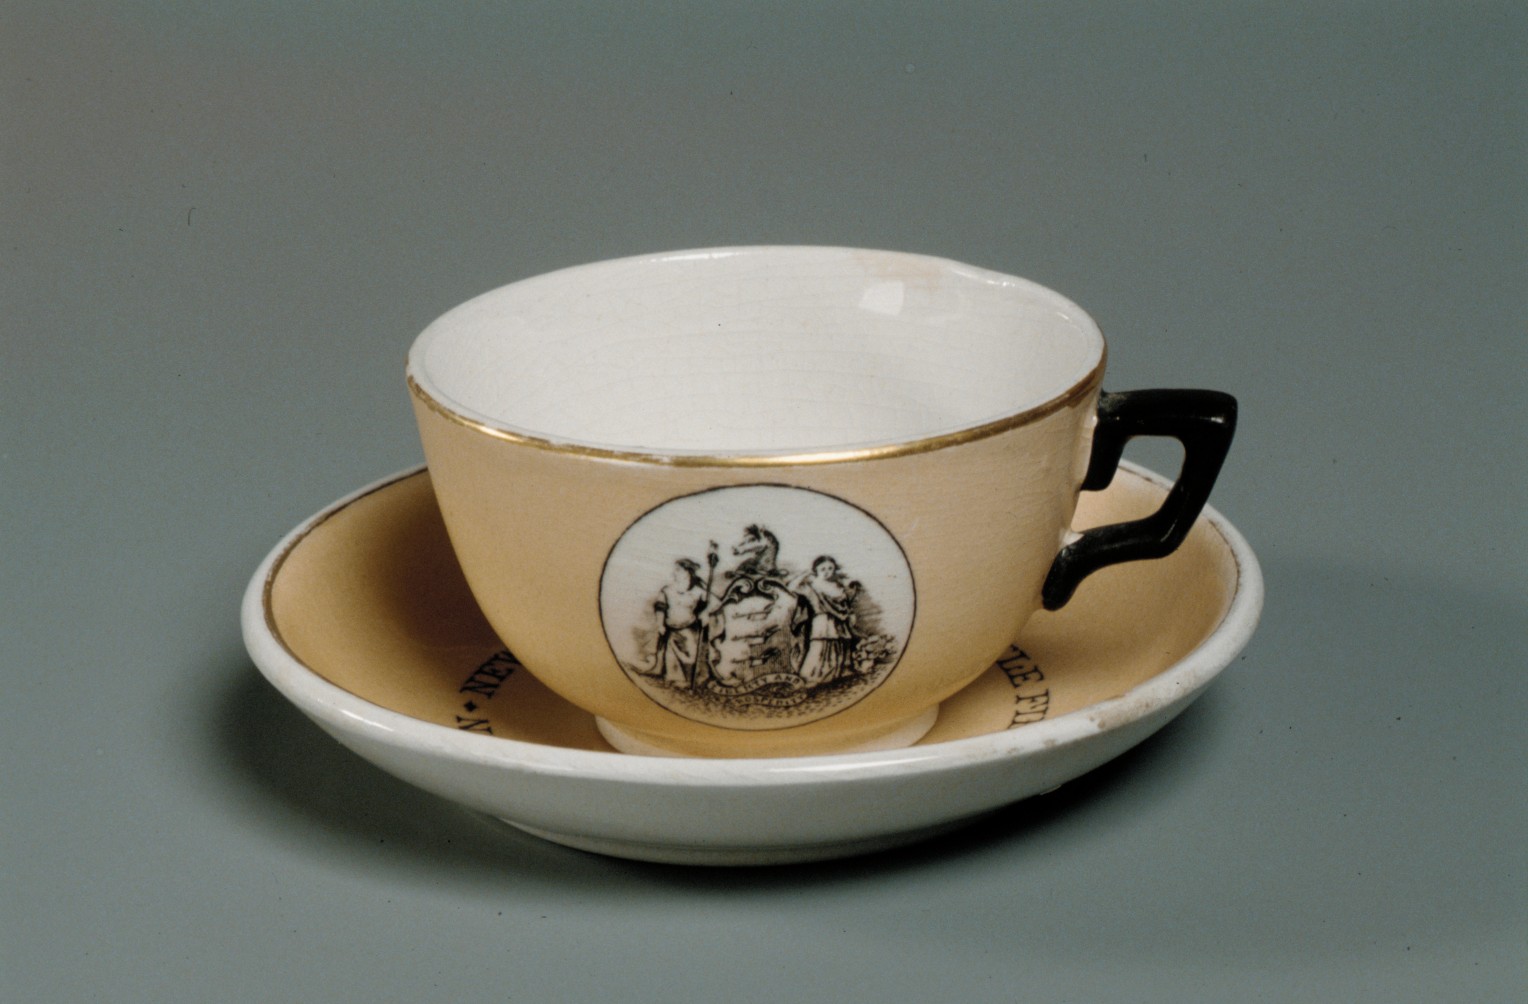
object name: cup and saucer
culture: american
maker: glasgow pottery company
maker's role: maker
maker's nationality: american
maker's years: 1856-1906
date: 1876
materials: earthenware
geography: united states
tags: coat of arms